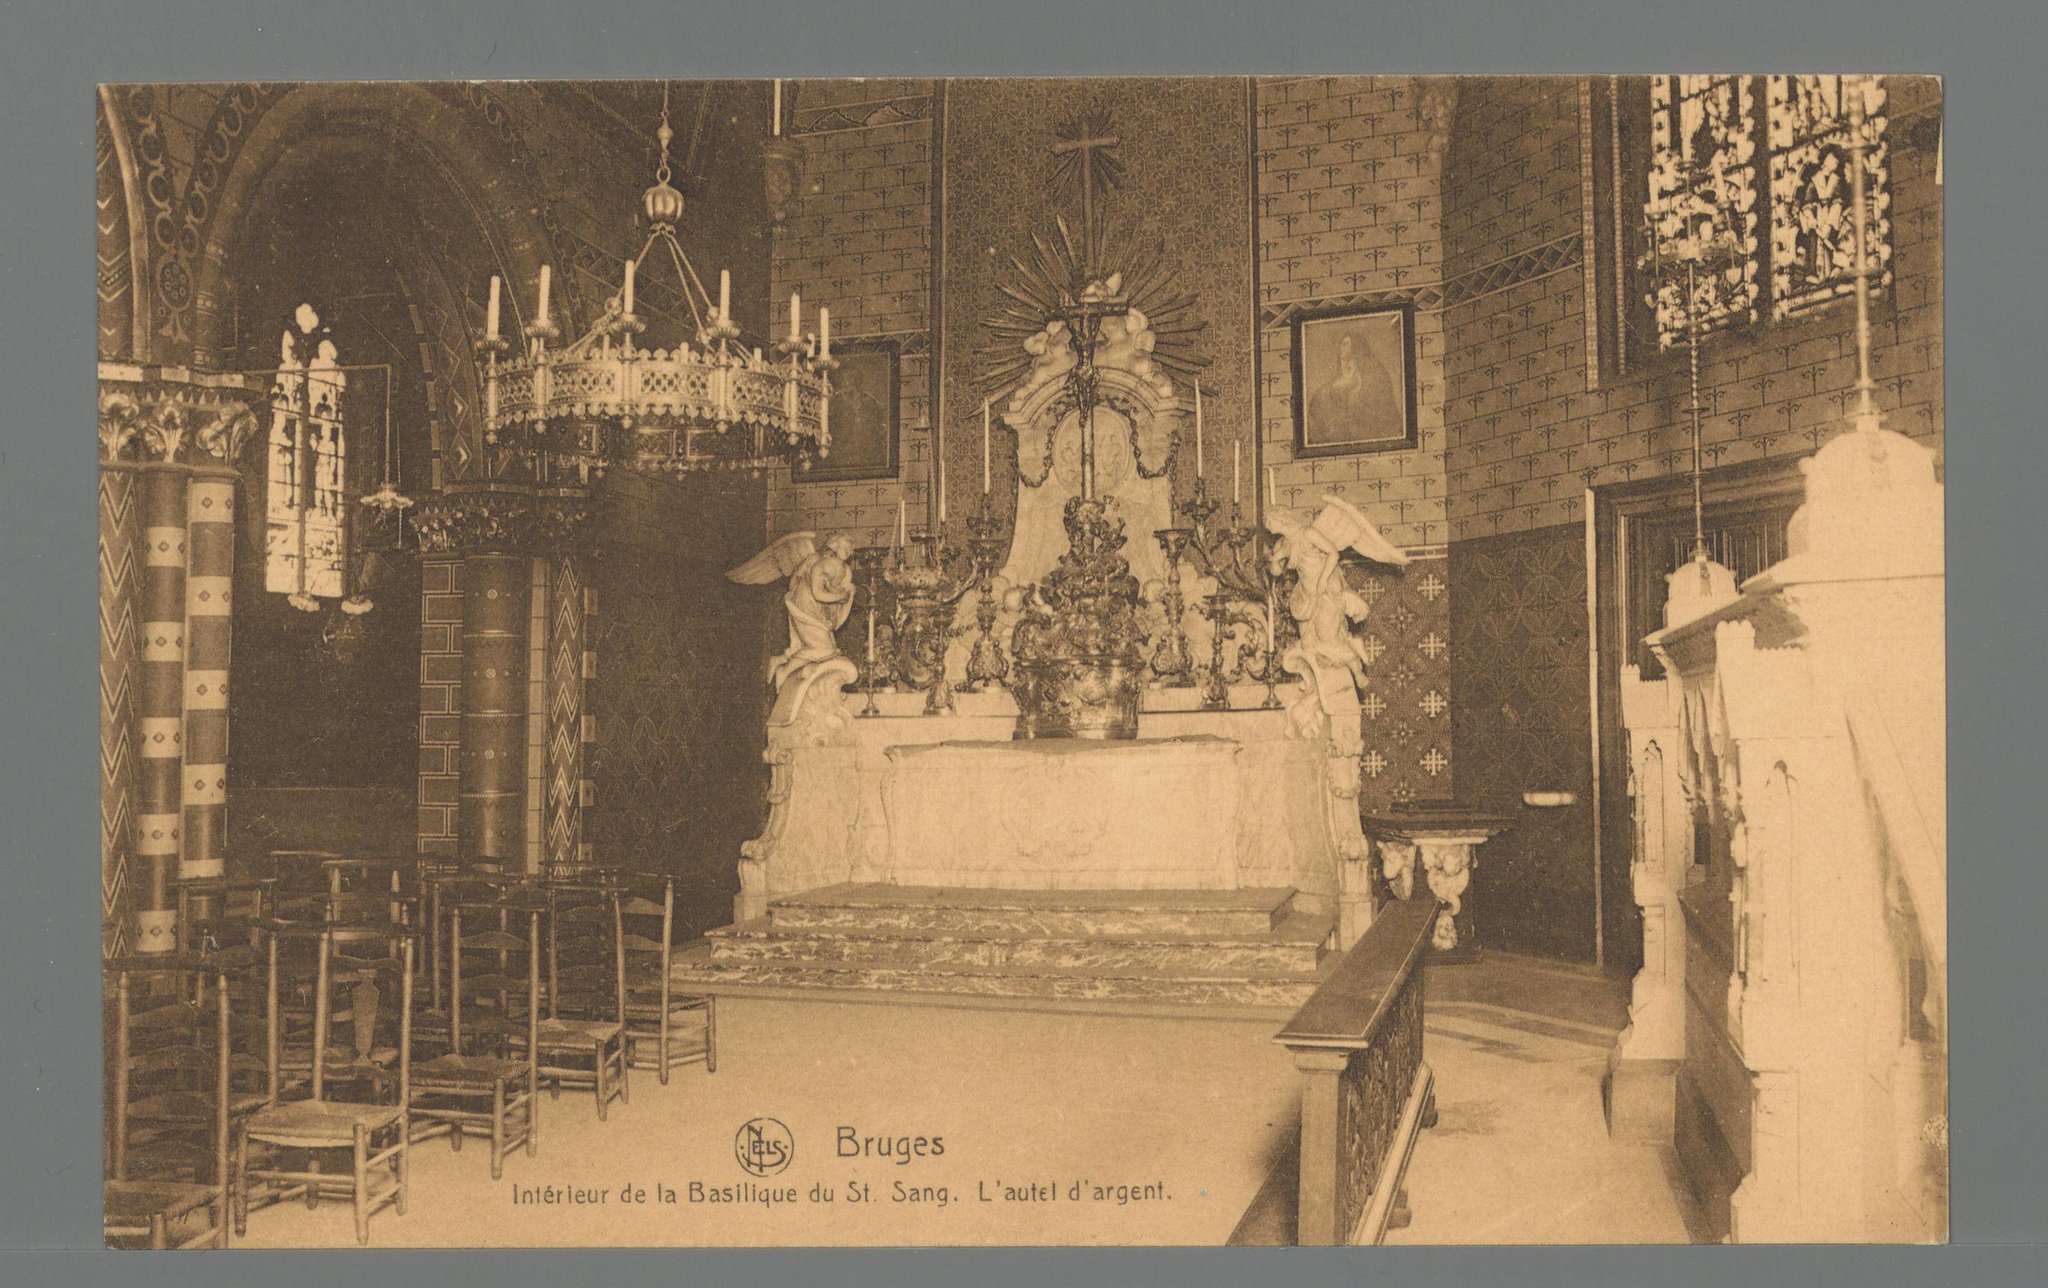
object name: ansichtkaart, prentbriefkaart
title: Bruges. Intérieur de la Basilique du St. Sang. L'autel de'argent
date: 1913-1930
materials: cardboard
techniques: photograph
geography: bruges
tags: church (exterior), altar